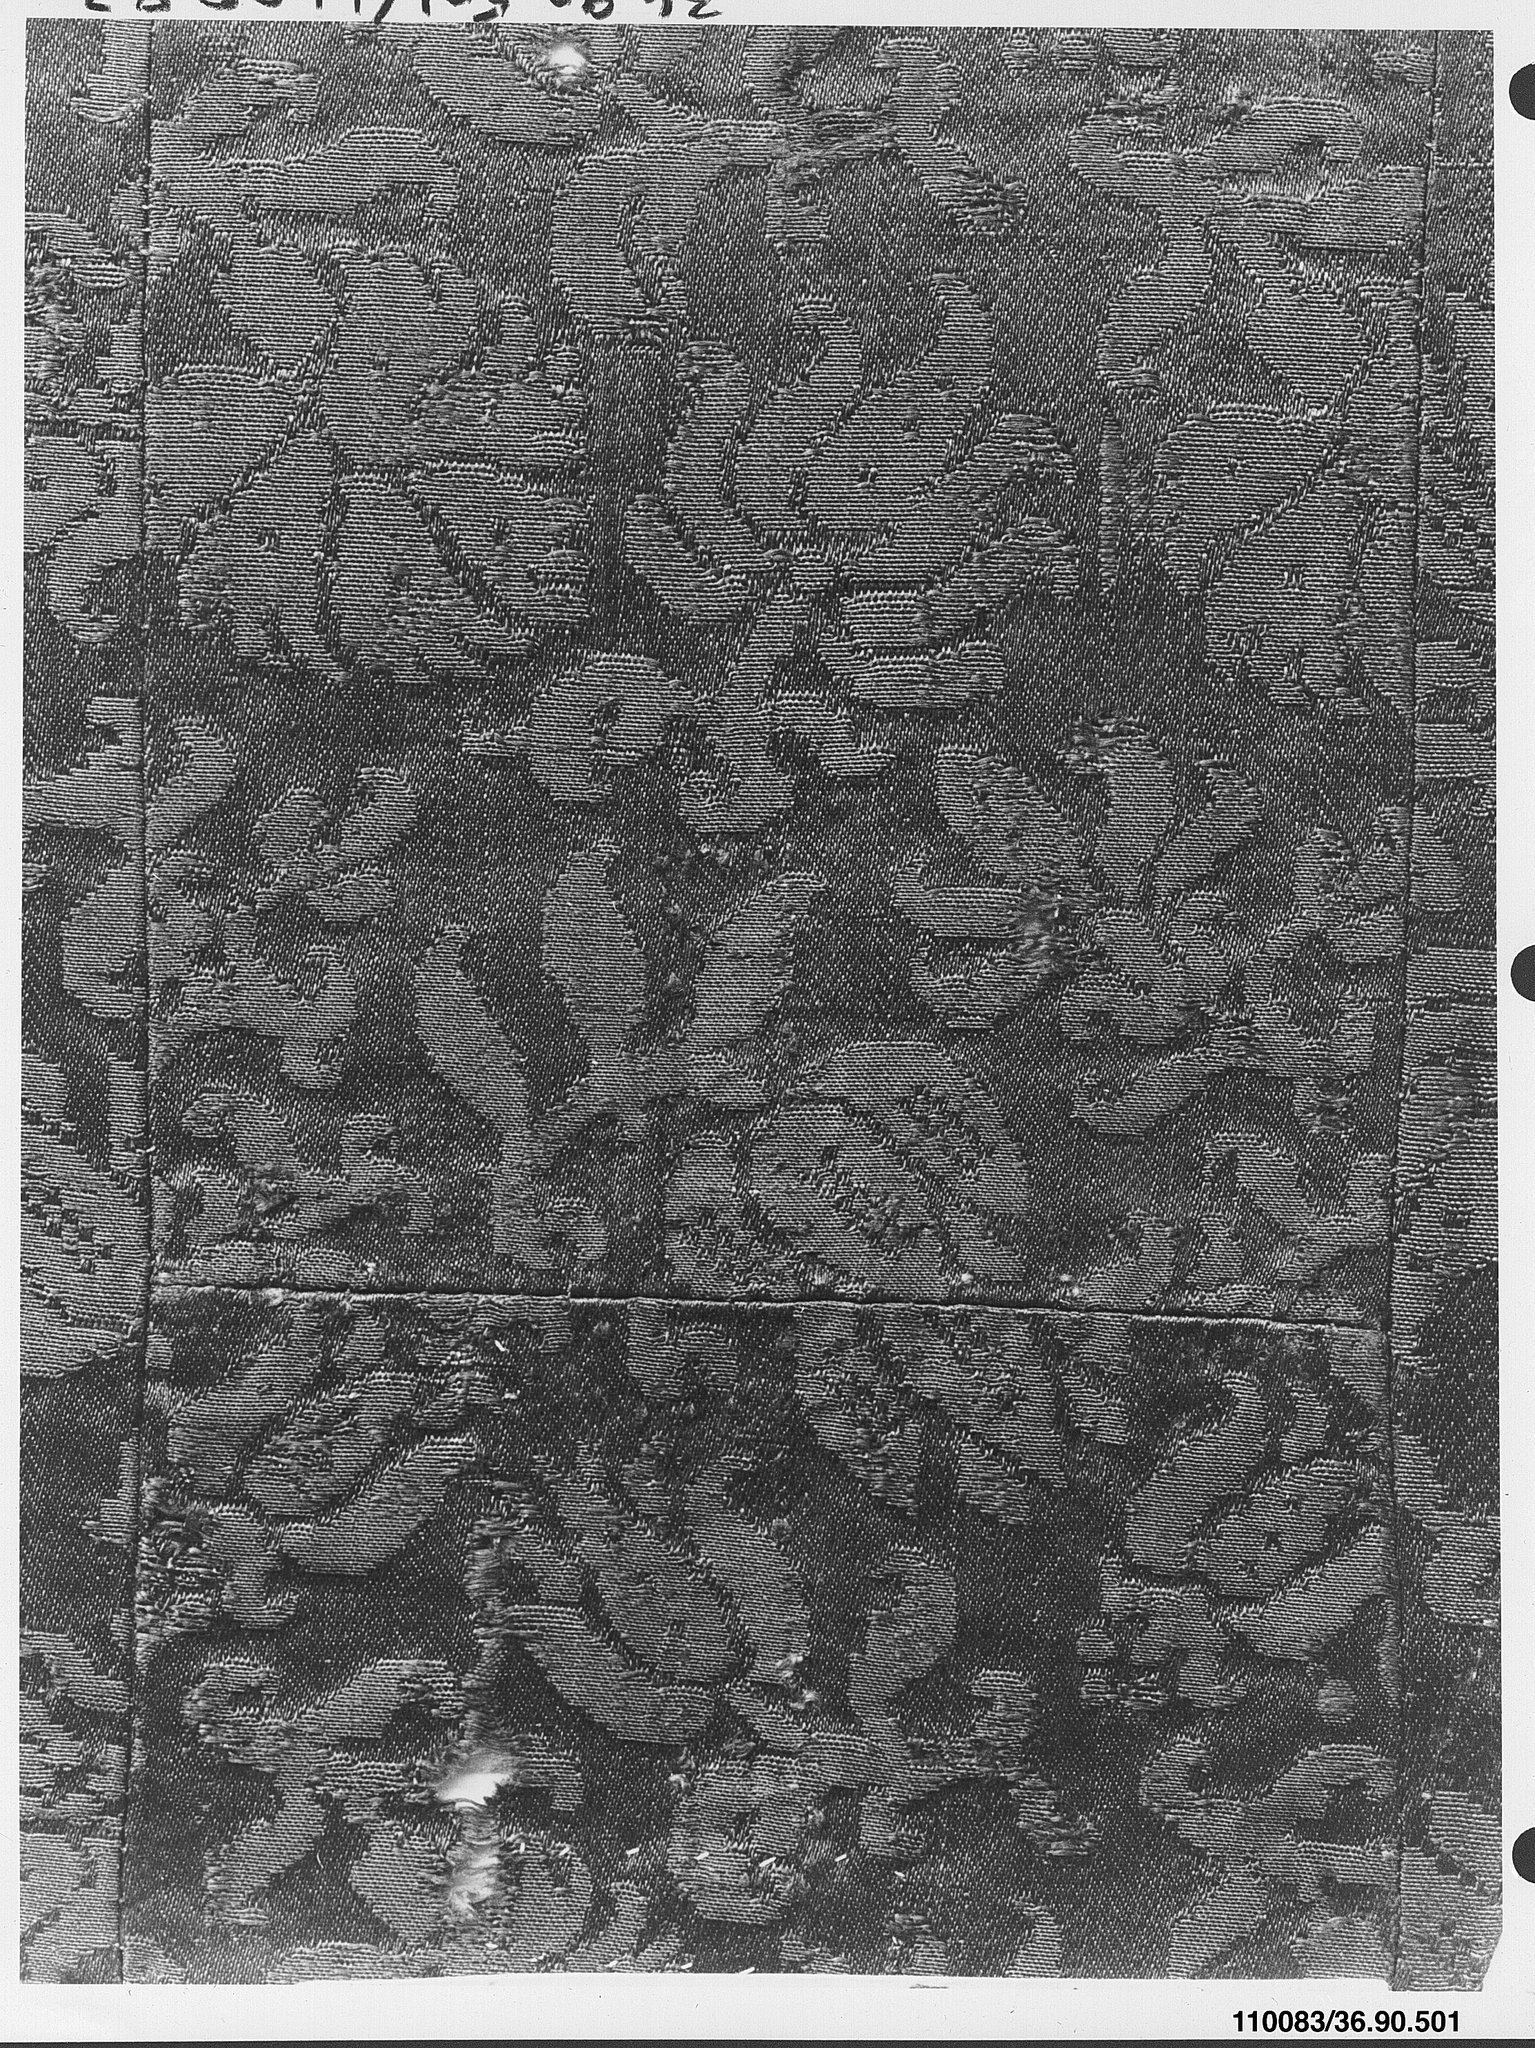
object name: piece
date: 1501-1700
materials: silk